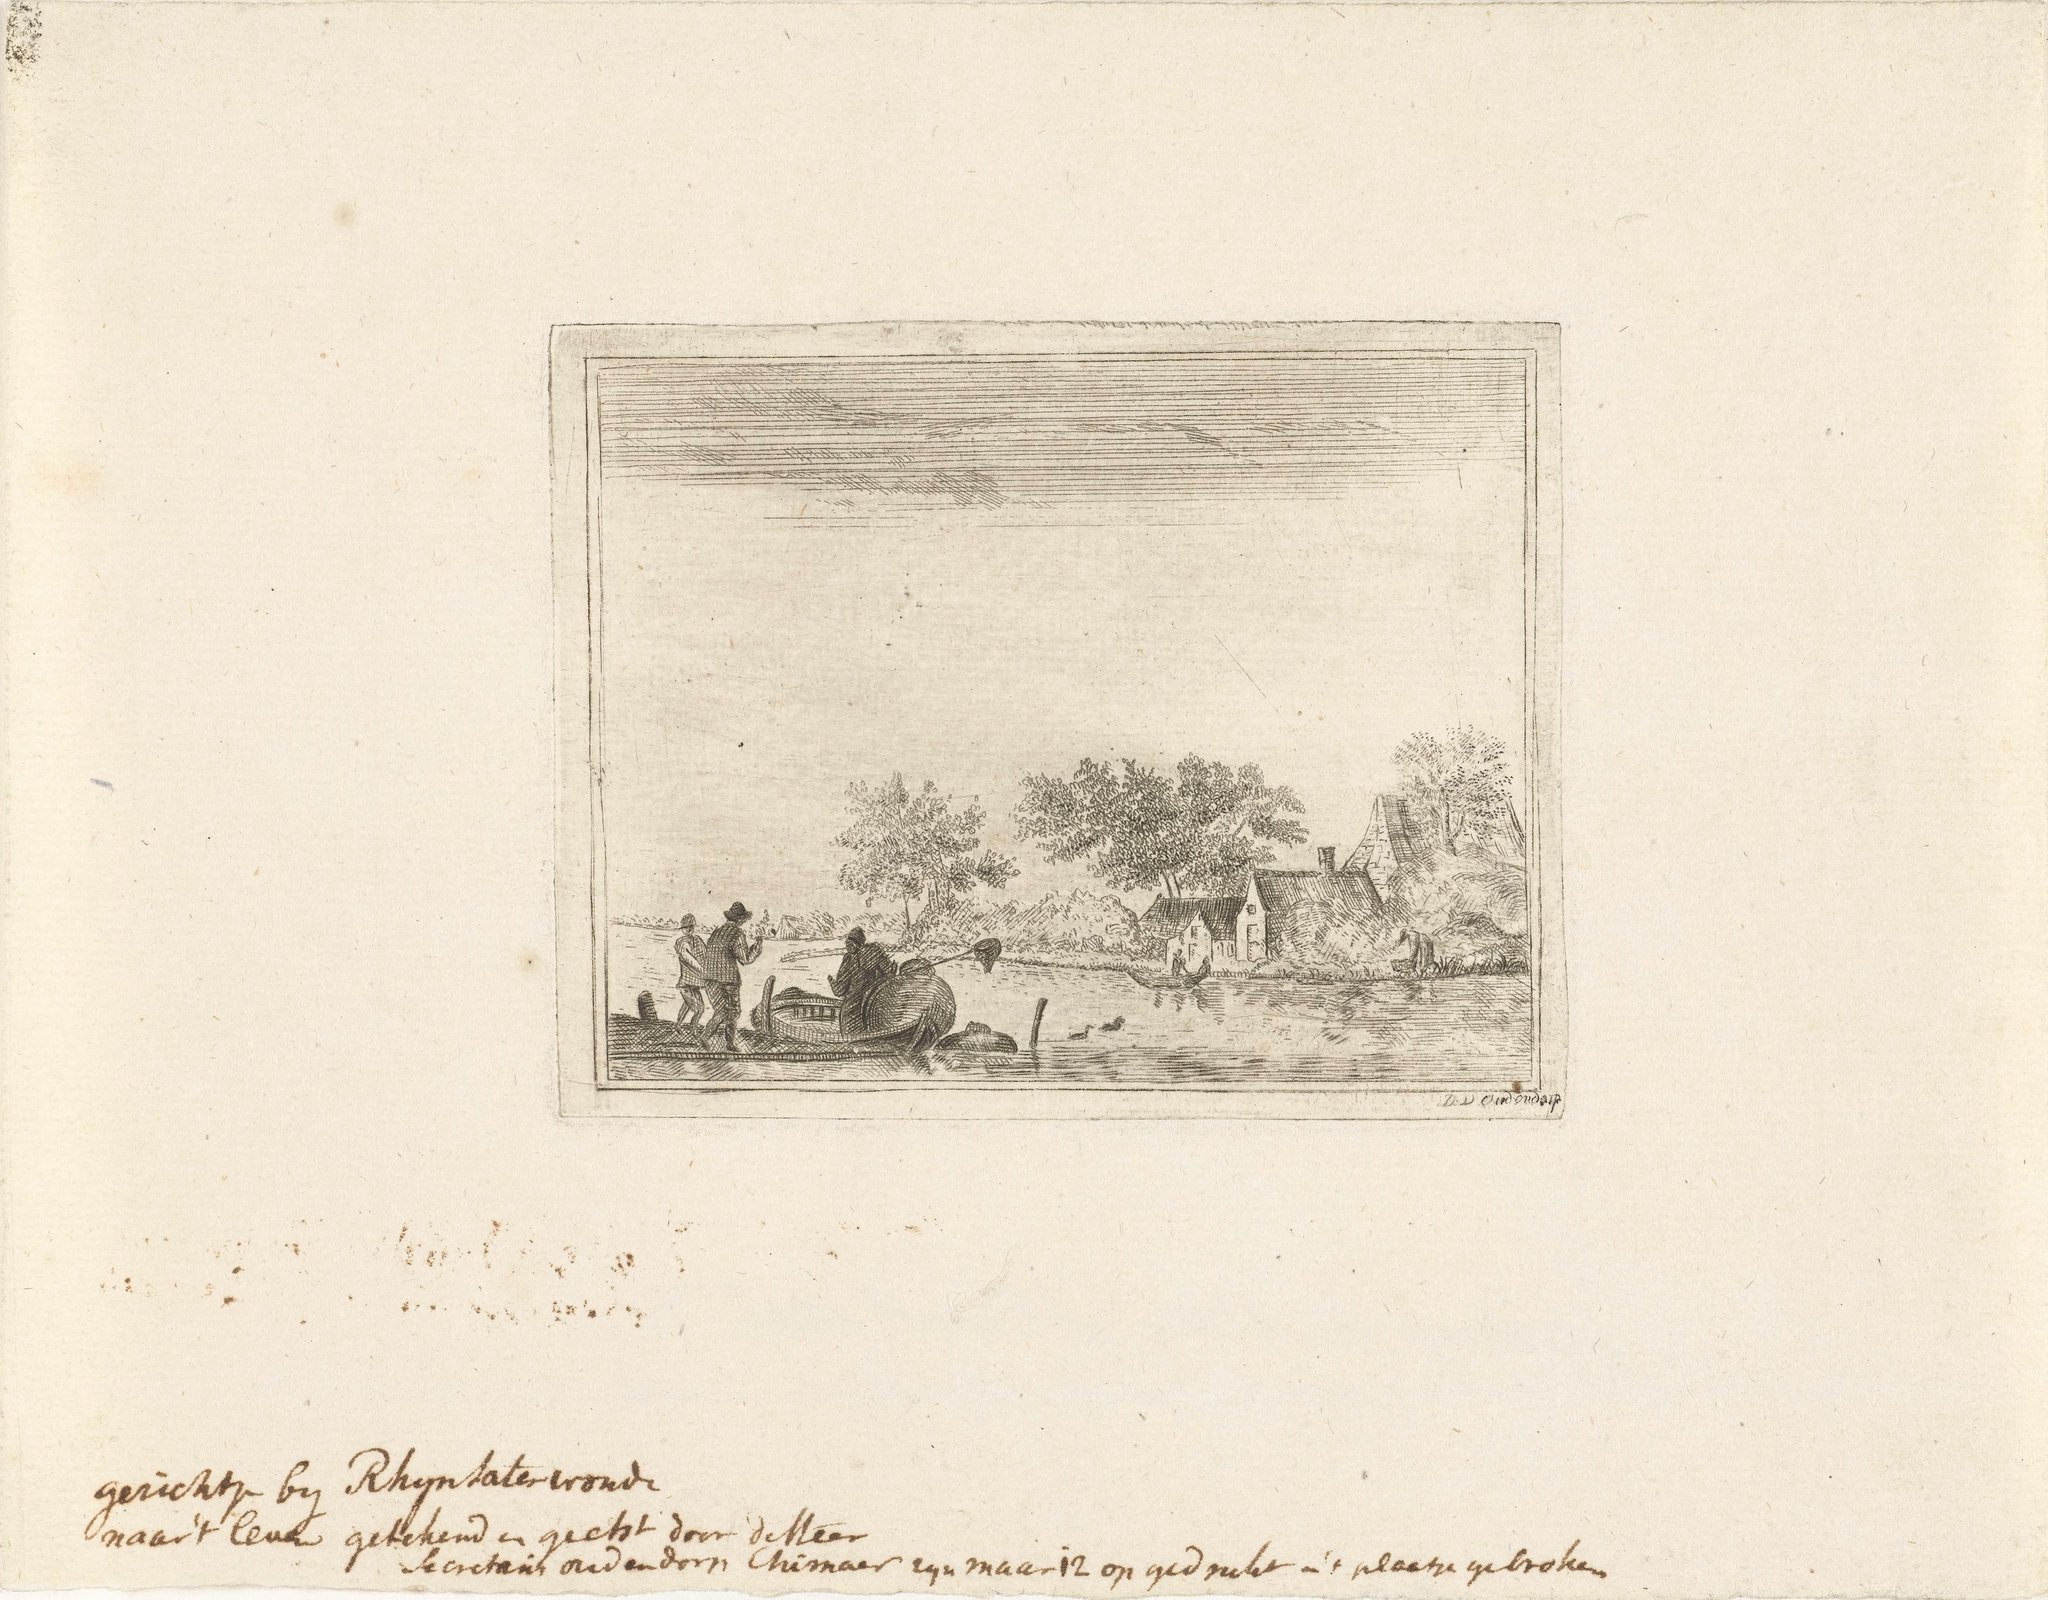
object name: print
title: Riviergezicht met roeiboot bij Rijnsaterwoude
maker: daniël nicolaas chimaer van oudendorp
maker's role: print maker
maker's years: 1797-1828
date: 1812-1828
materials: paper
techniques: etching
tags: river (+ landscape with figures, staffage)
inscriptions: collector's mark: Lugt 2228, inscription: ‘Gezicht by Rhynsaterwoude naar't leven getekend en geetst door de heer [...] Oudendorp Chimaer zyn maar 12 op gedrukt - 't plaatje gebroken’